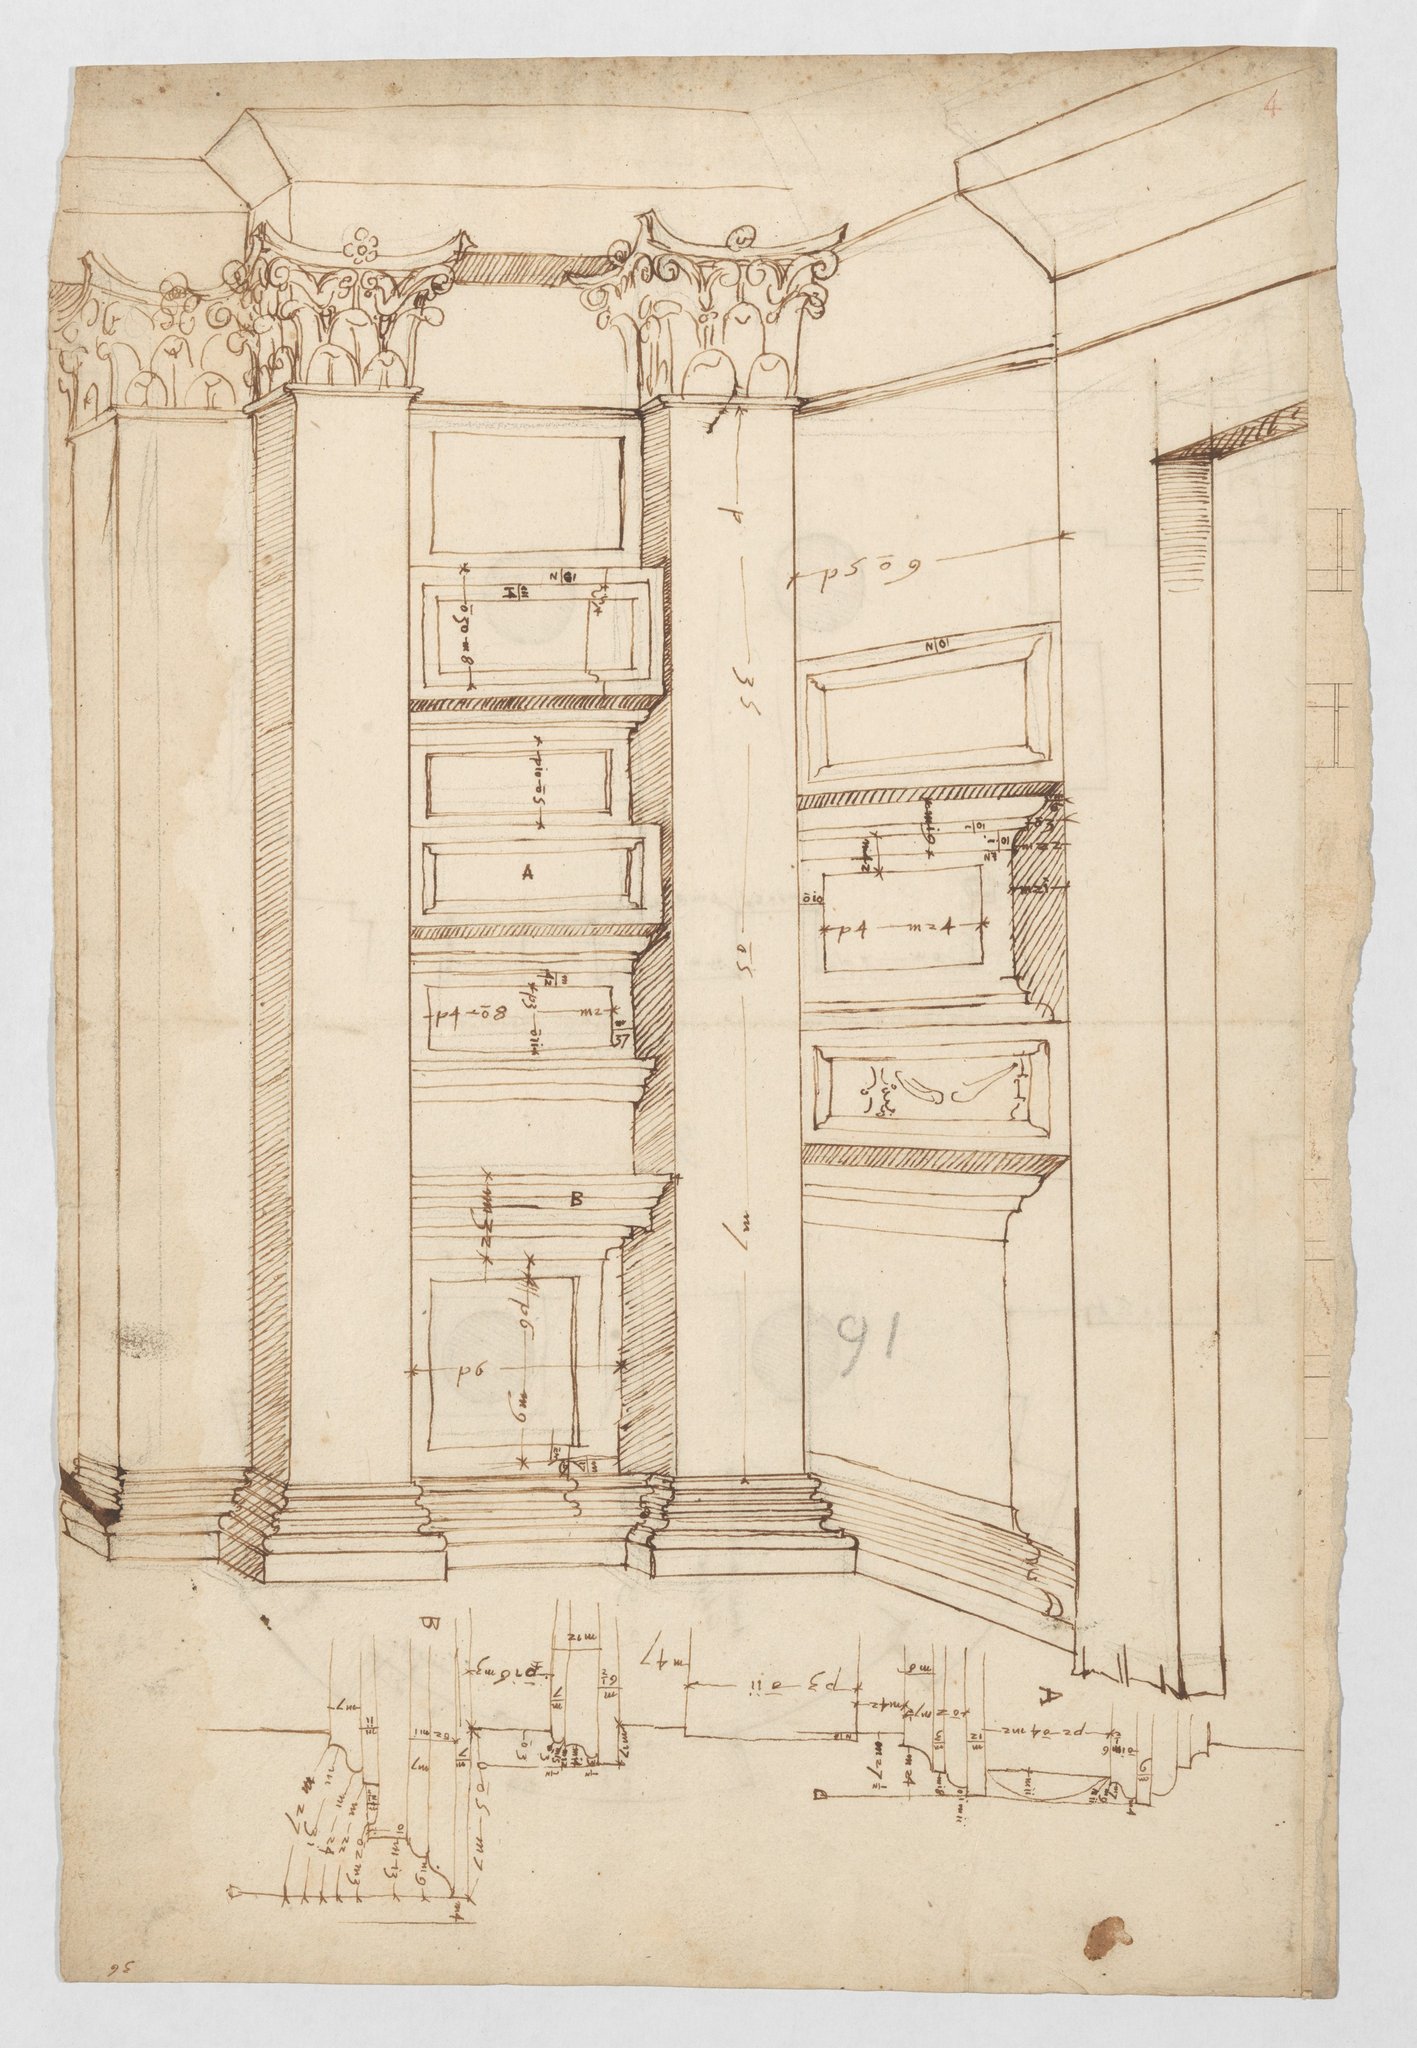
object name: collection ornament architecture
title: Pantheon, vestibule, perspective; panel moulding, profiles (recto) Pantheon, rectangular niche, plan; half round niche, plan (verso)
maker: anonymous, french, 16th century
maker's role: draftsman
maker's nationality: french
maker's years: 1500-1600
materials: chalk, ink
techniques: incising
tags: architecture